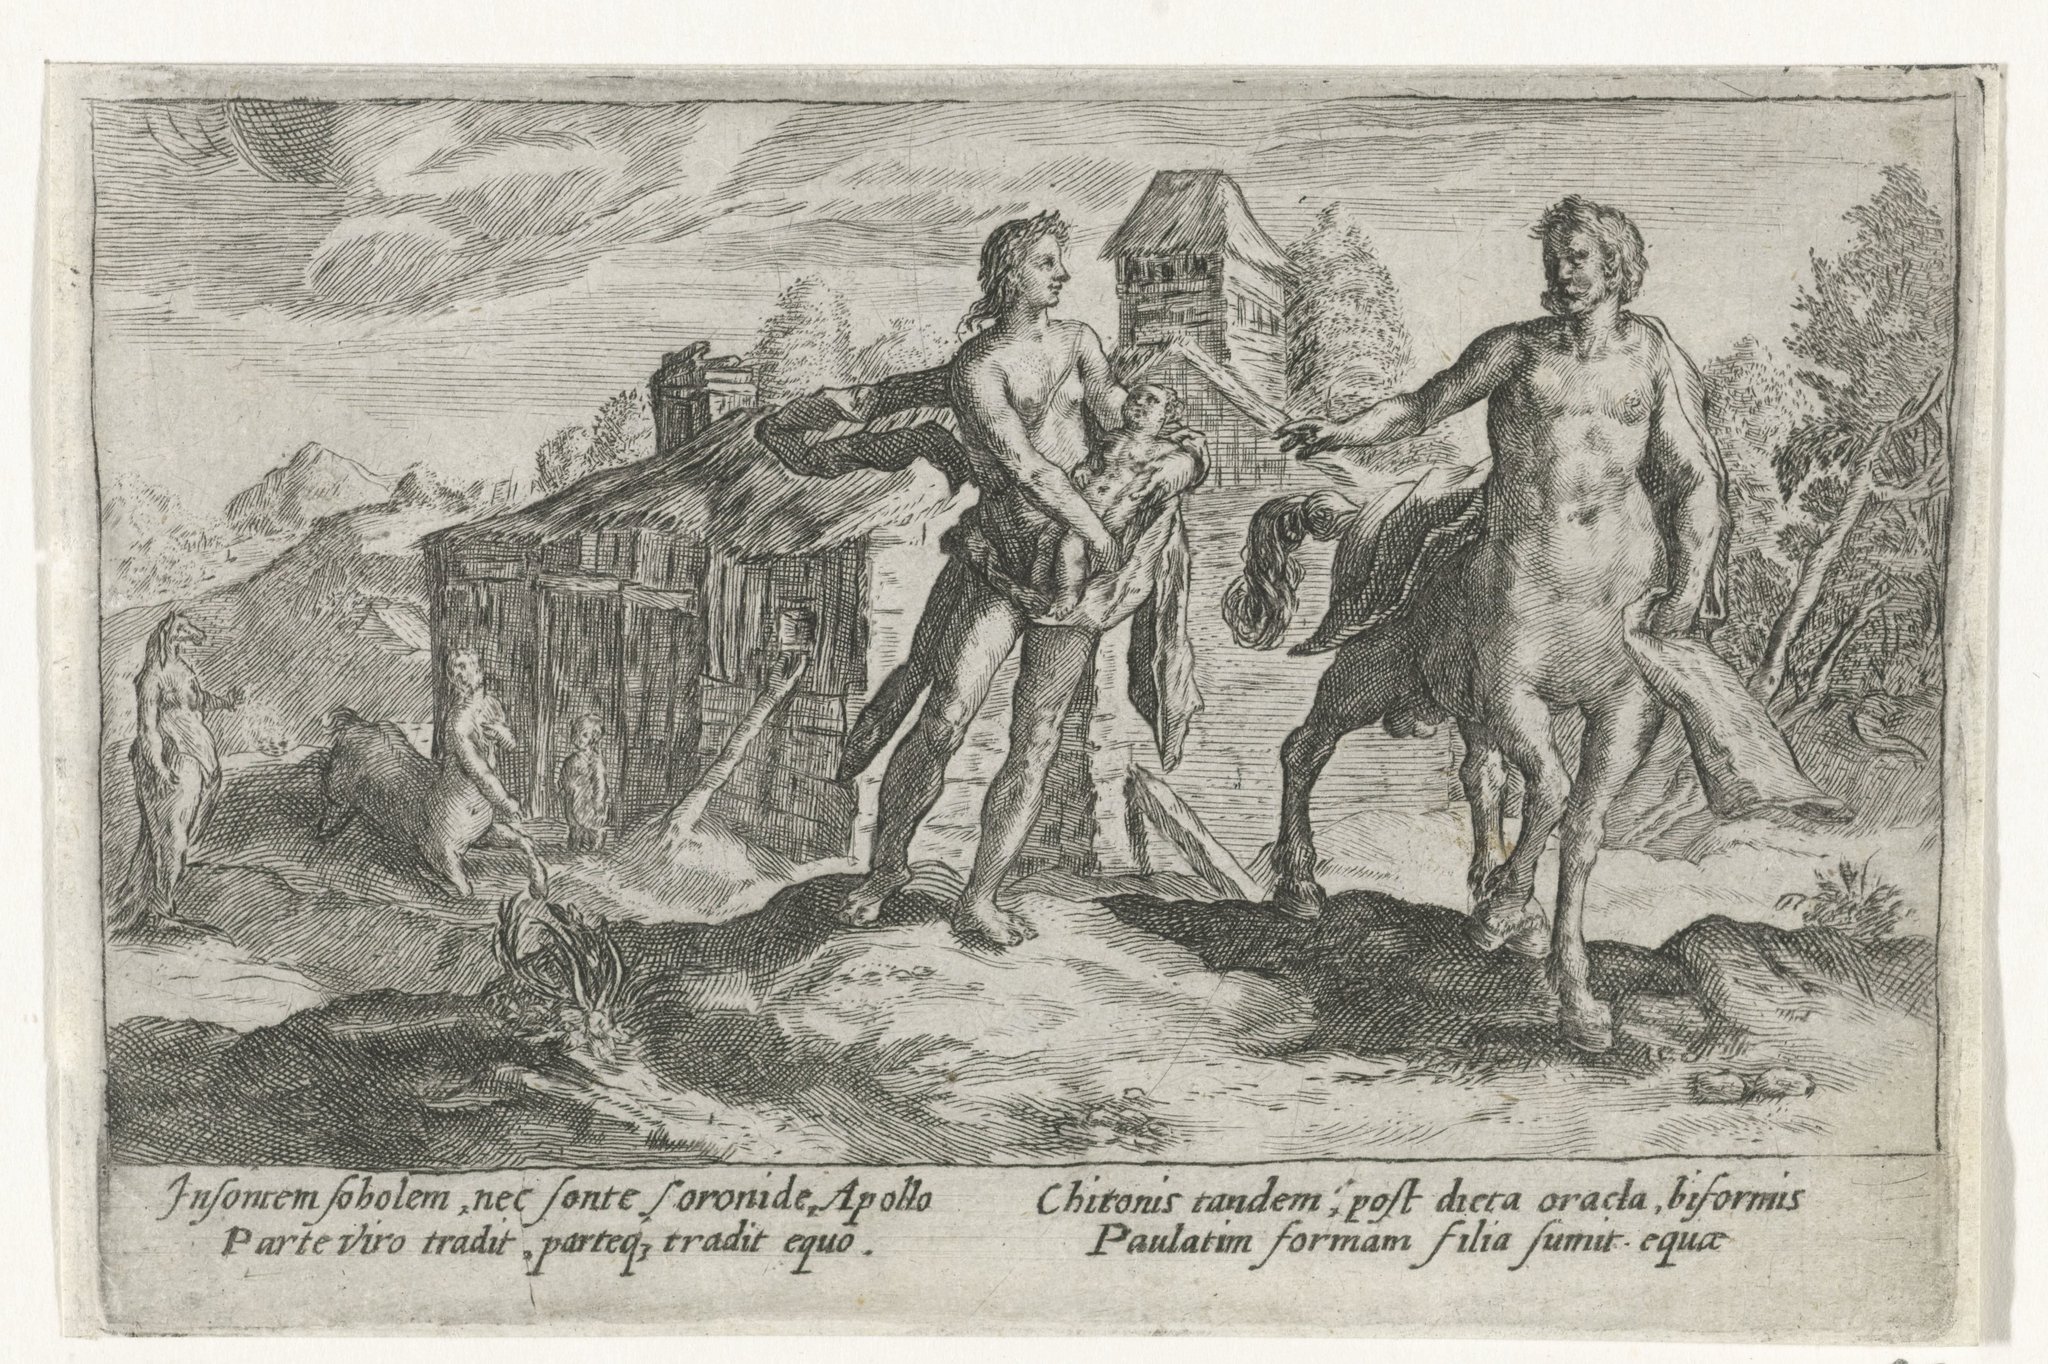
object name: print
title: Apollo vertrouwt Aesculapius toe aan Chiron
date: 1602-1607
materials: paper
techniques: engraving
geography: cologne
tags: apollo hands aesculapius over to chiron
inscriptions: collector's mark: Lugt 2228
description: Apollo overhandigt zijn zoon Aesculapius, het kind van Apollo en Coronis, aan de centaur Chiron die het kind zal opvoeden. Het kind groeide op tot de god van de geneeskunde. In de marge een vierregelig onderschrift, in twee kolommen, in het Latijn.